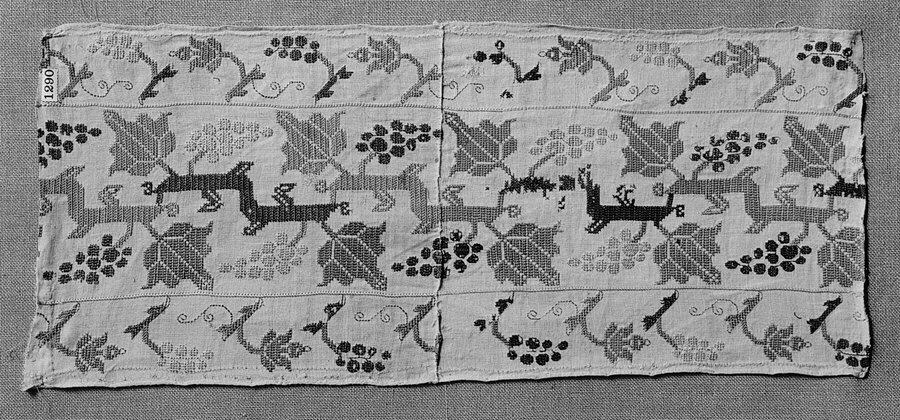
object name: band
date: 1501-1600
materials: linen